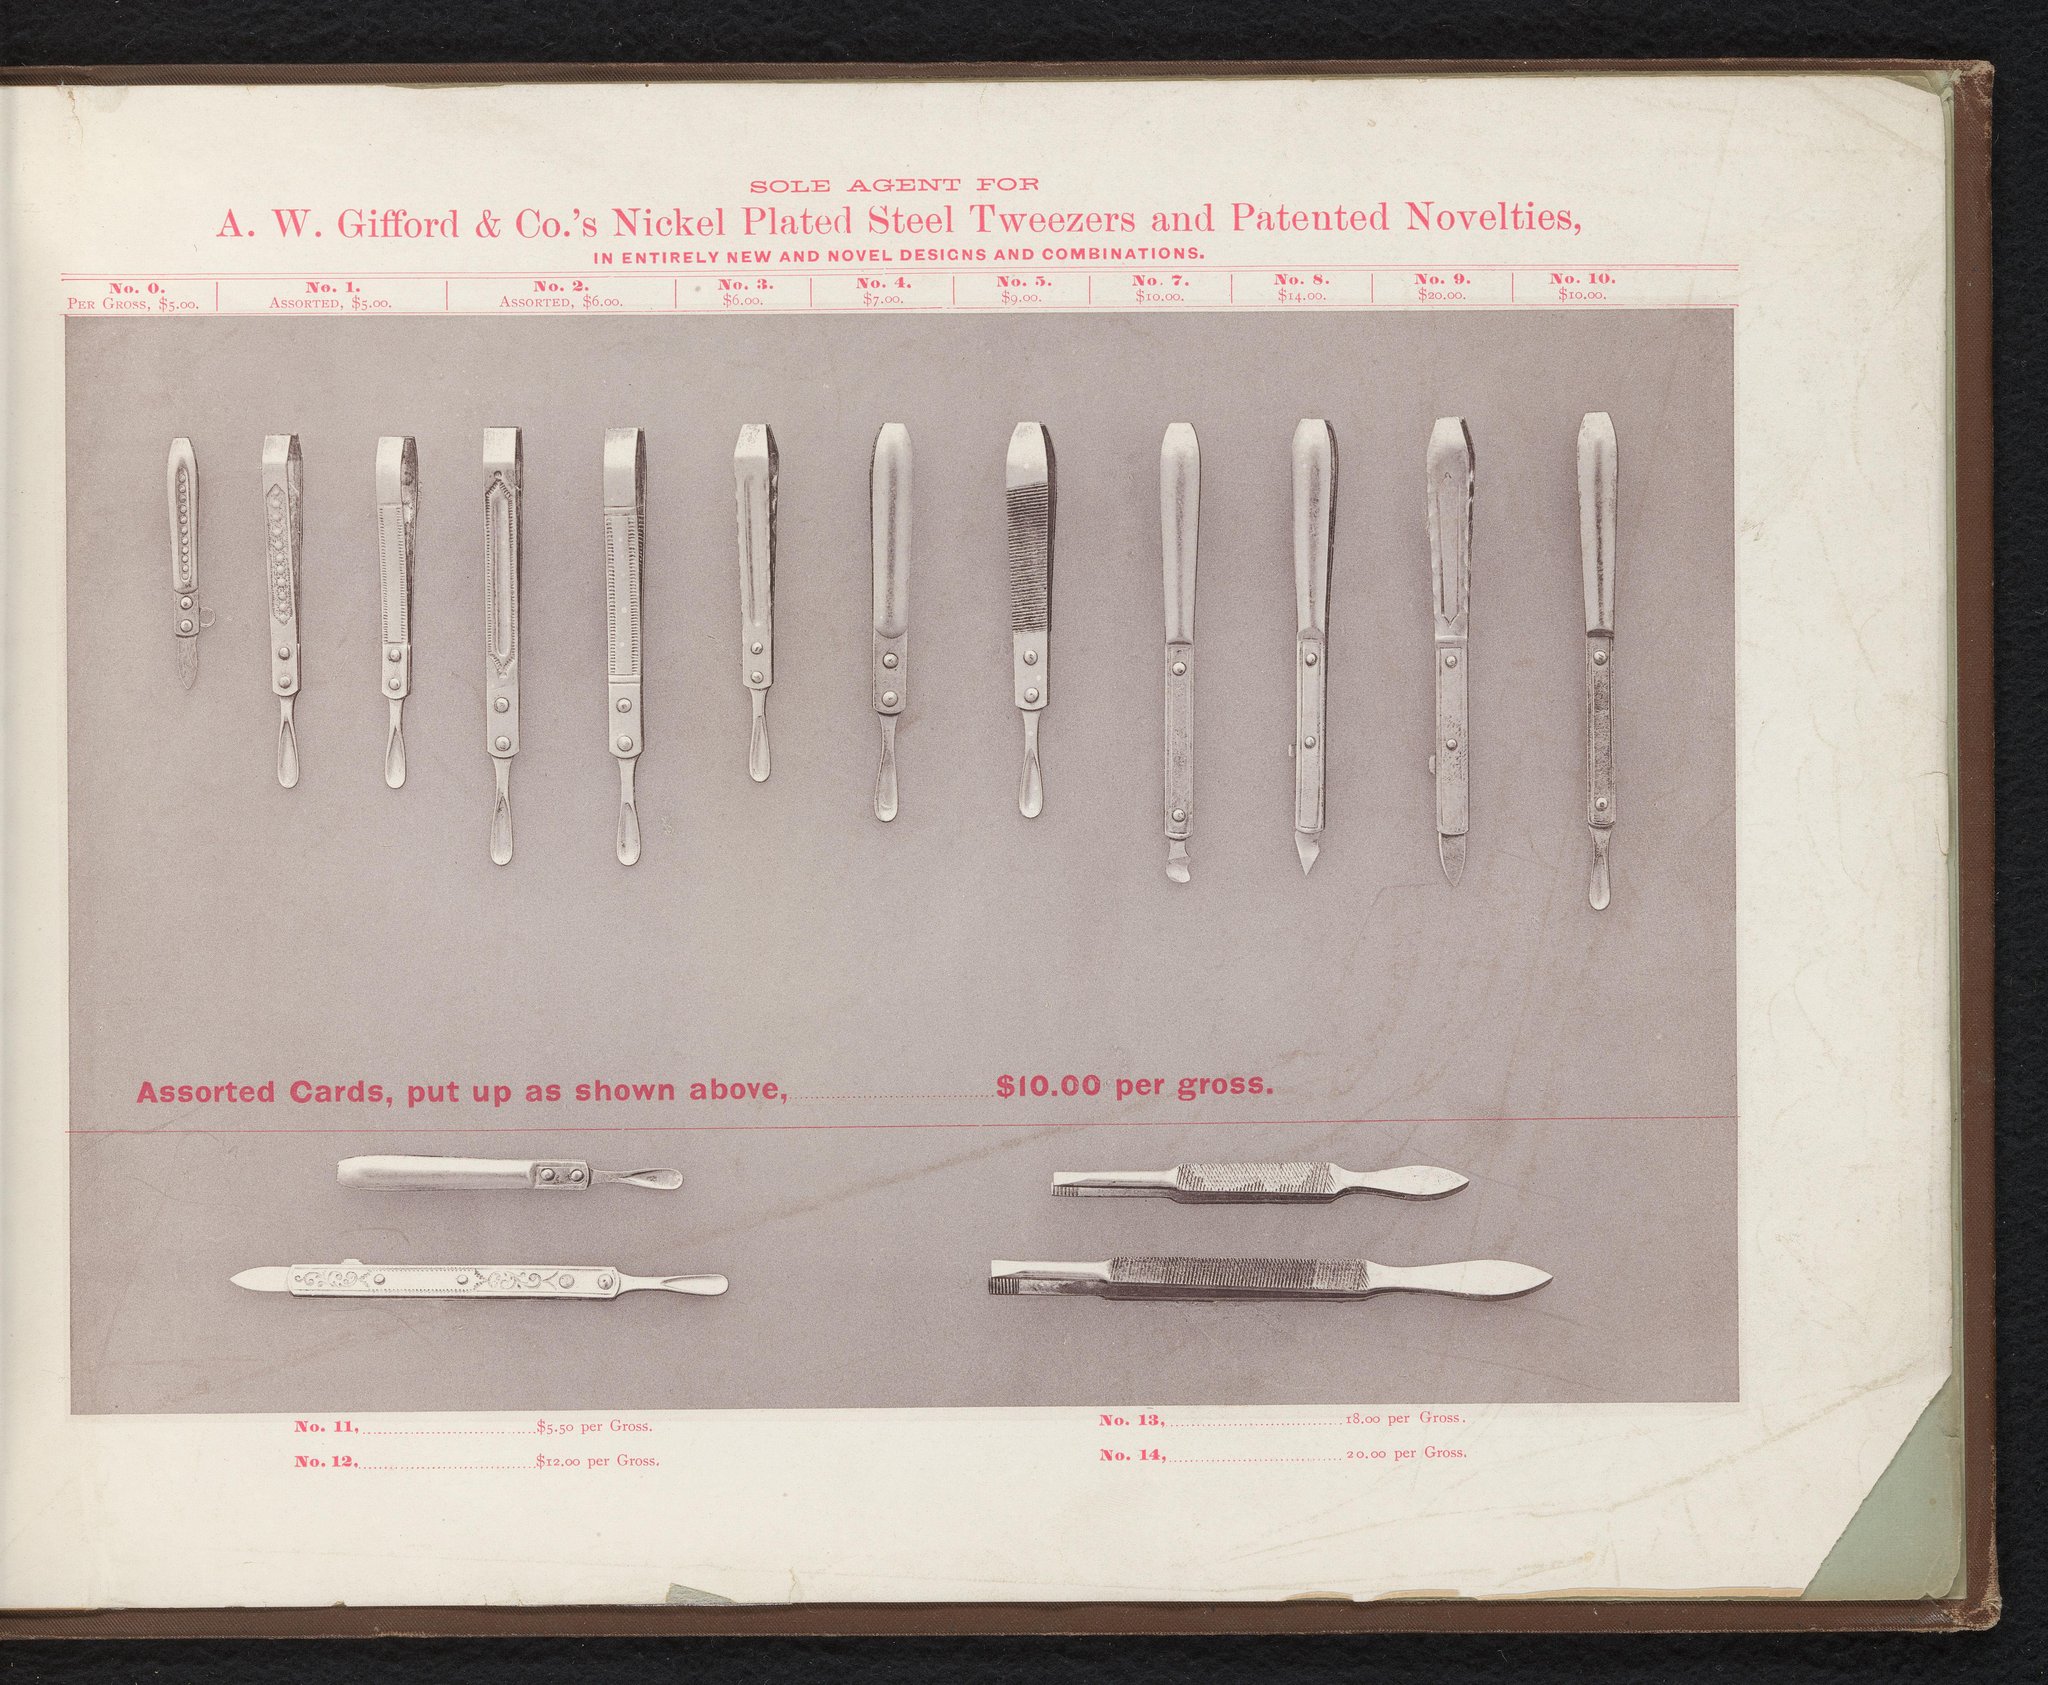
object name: photomechanical print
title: A.W. Gifford & Co.'s nickel plated steel tweezers and patented novelties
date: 1876-1881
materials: paper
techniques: photograph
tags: care of the body, hygiene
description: Prent op ongenummerde pagina na pagina 18.